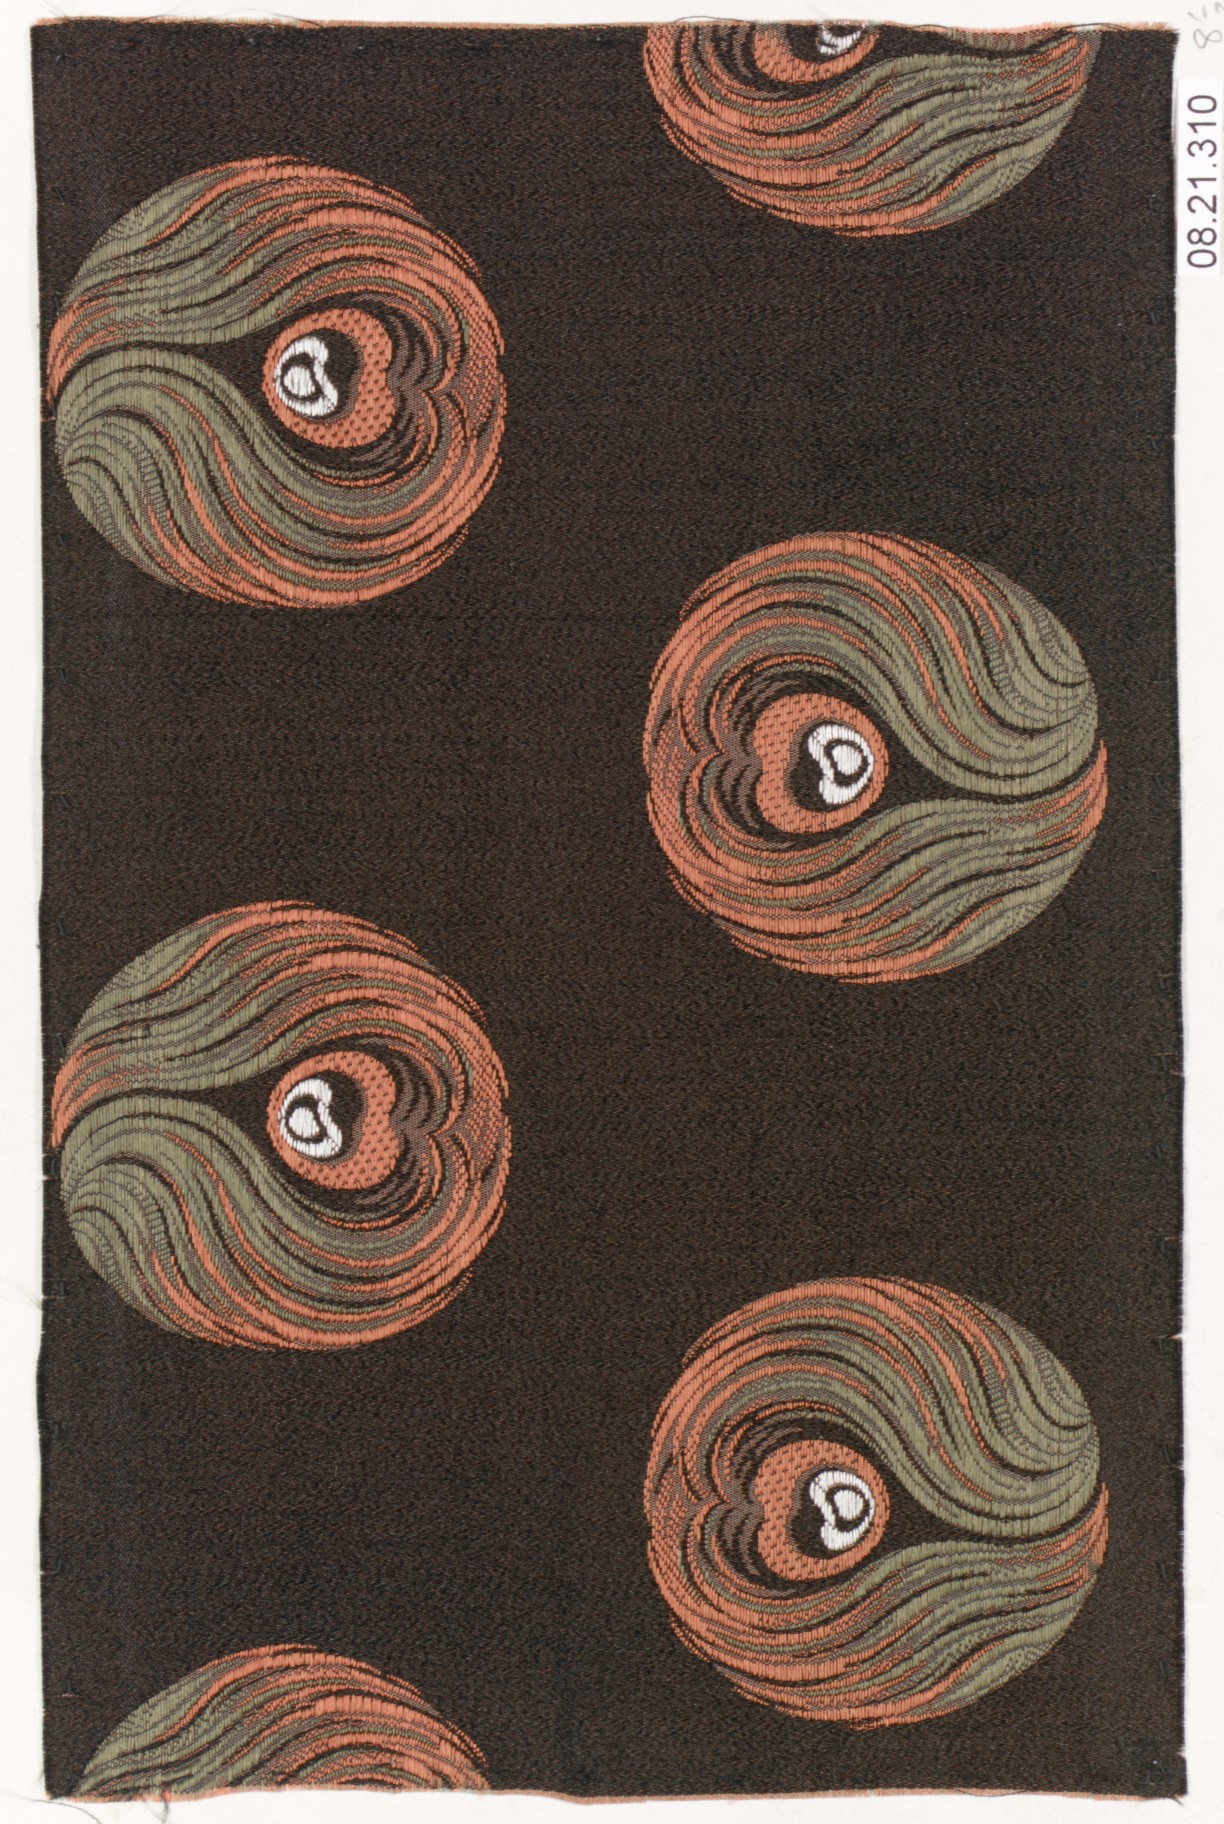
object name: textile sample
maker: Anonymous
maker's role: designer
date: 1900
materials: silk